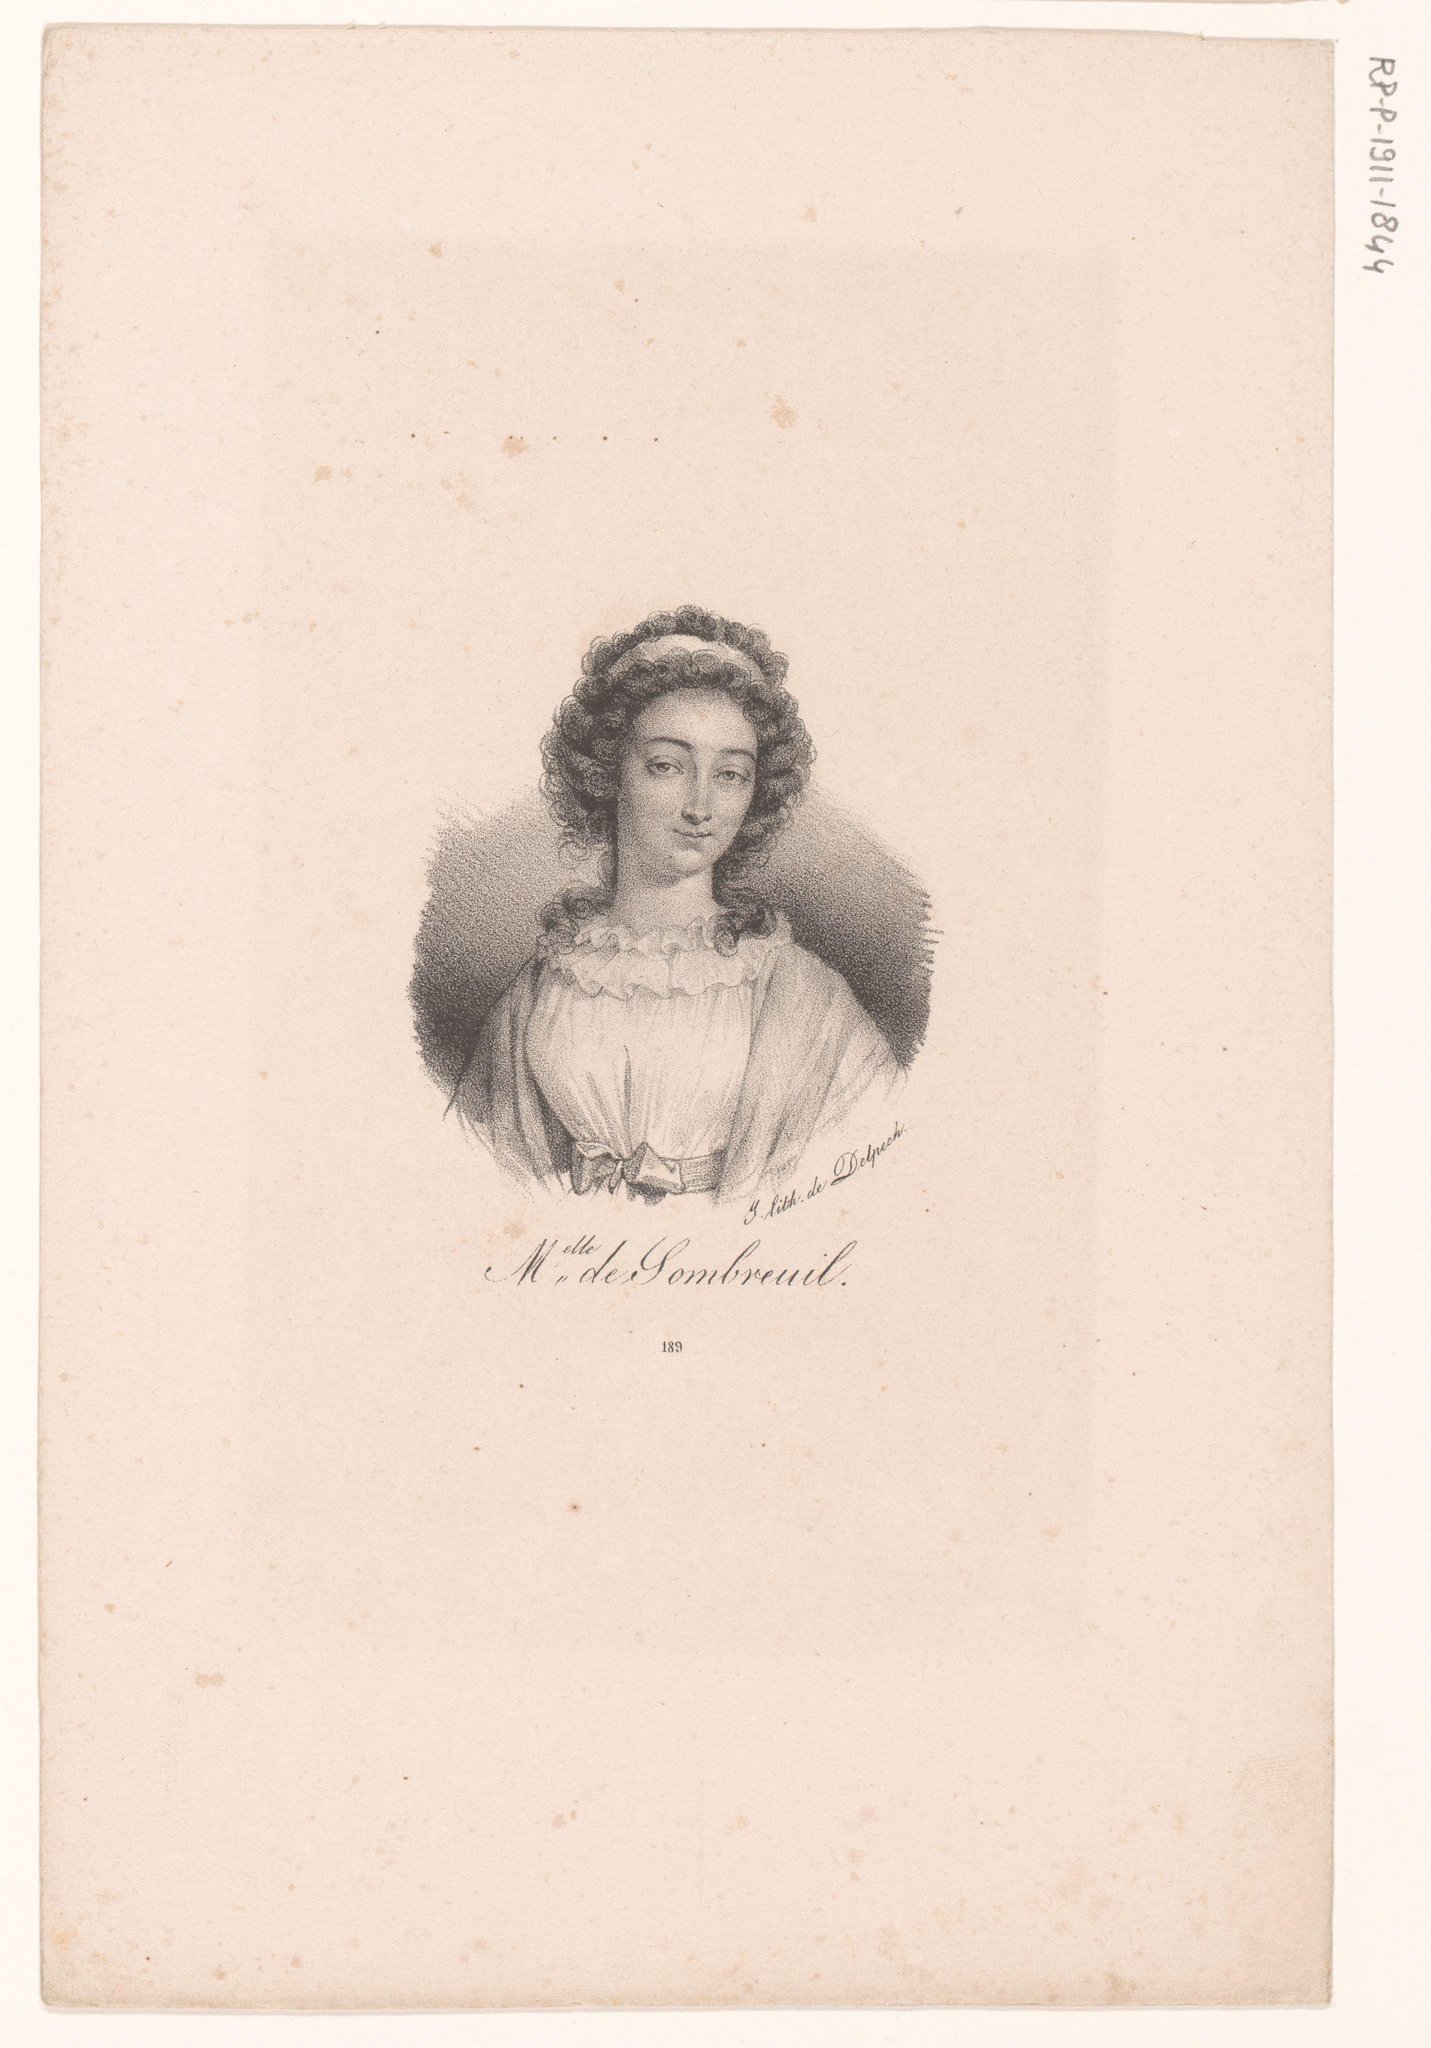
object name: print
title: Portret van Marie-Maurille de Sombreuil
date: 1818-1842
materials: paper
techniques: lithograph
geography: paris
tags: historical persons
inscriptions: collector's mark: Lugt 2228a